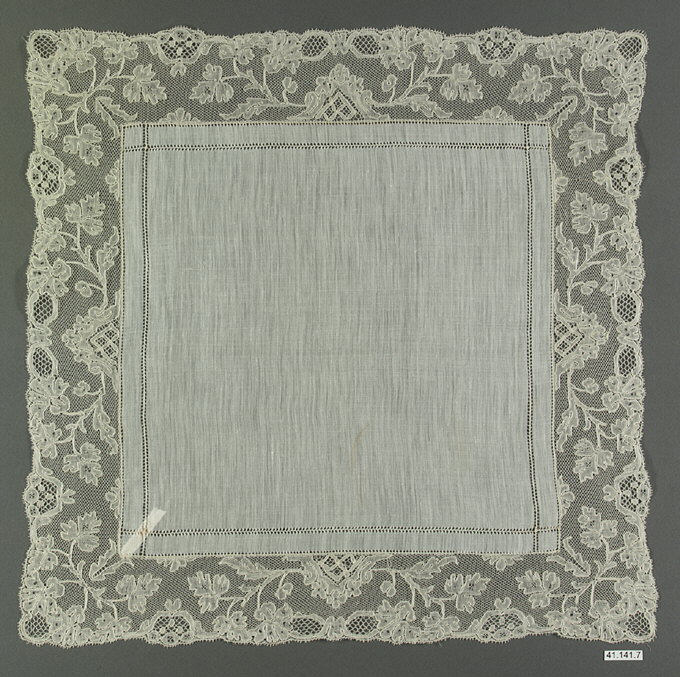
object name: handkerchief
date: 1867-1900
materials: lace, linen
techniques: lace, embroidery